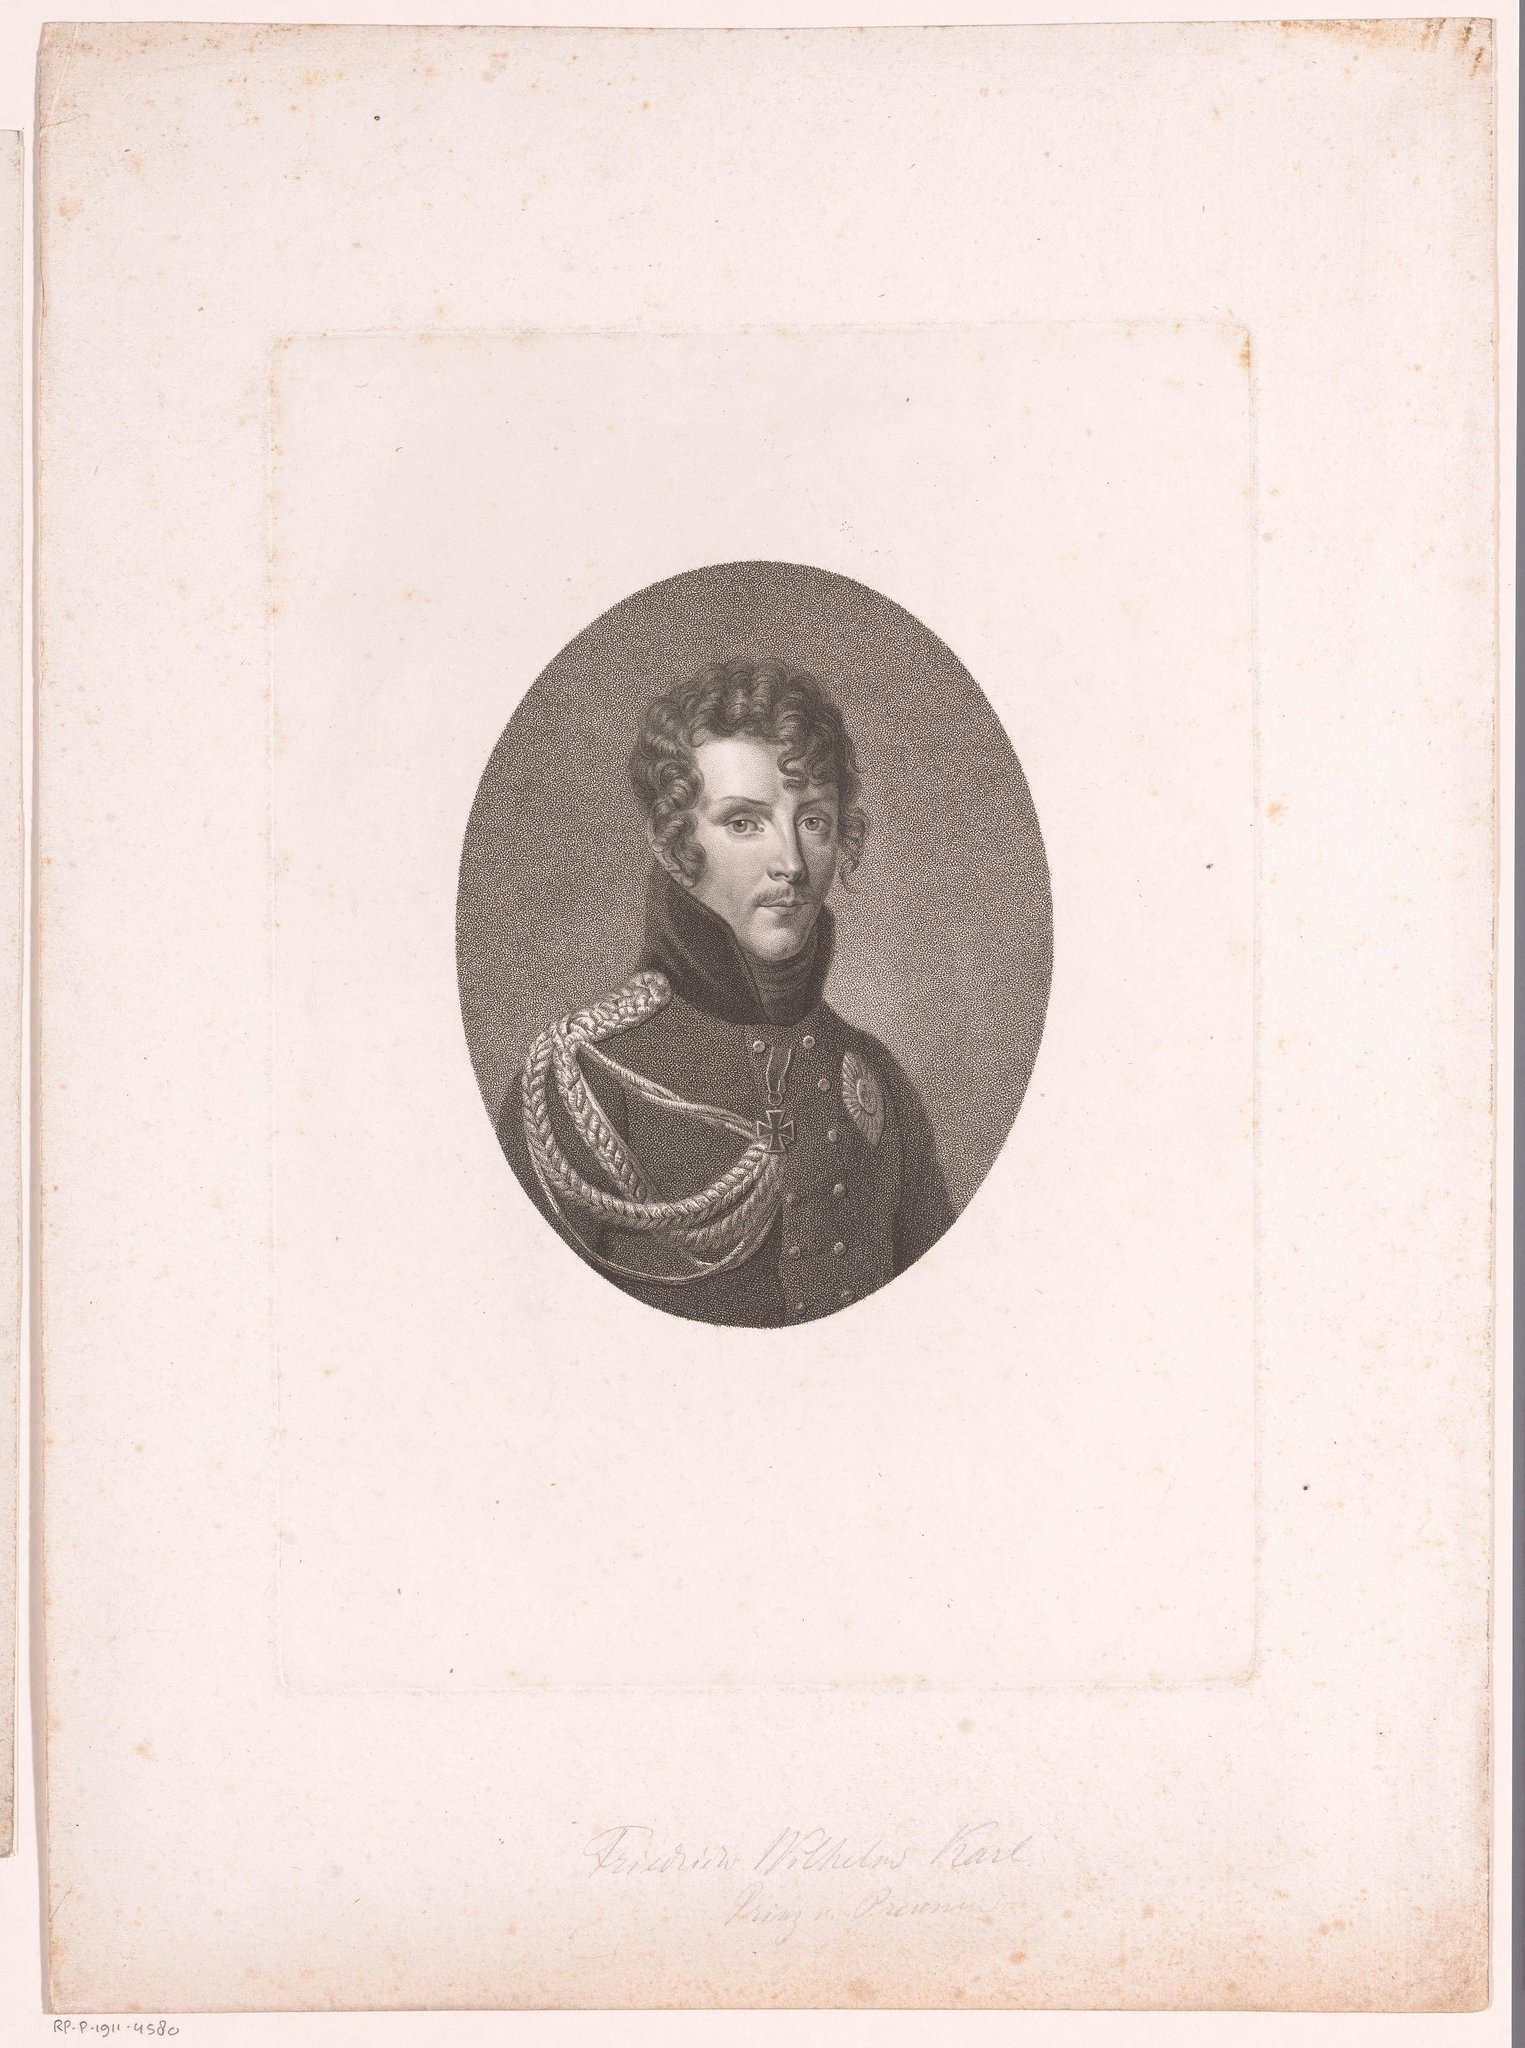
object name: print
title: Portret van Friedrich Wilhelm Karl van Pruisen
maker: friedrich wilhelm bollinger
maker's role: print maker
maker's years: 1777-1825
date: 1800-1825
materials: paper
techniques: stippling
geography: berlin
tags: knighthood order (with name) - insignia of a knighthood order, e.g.: badge, chain (with name of order), knighthood order, historical persons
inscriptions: collector's mark: Lugt 2228